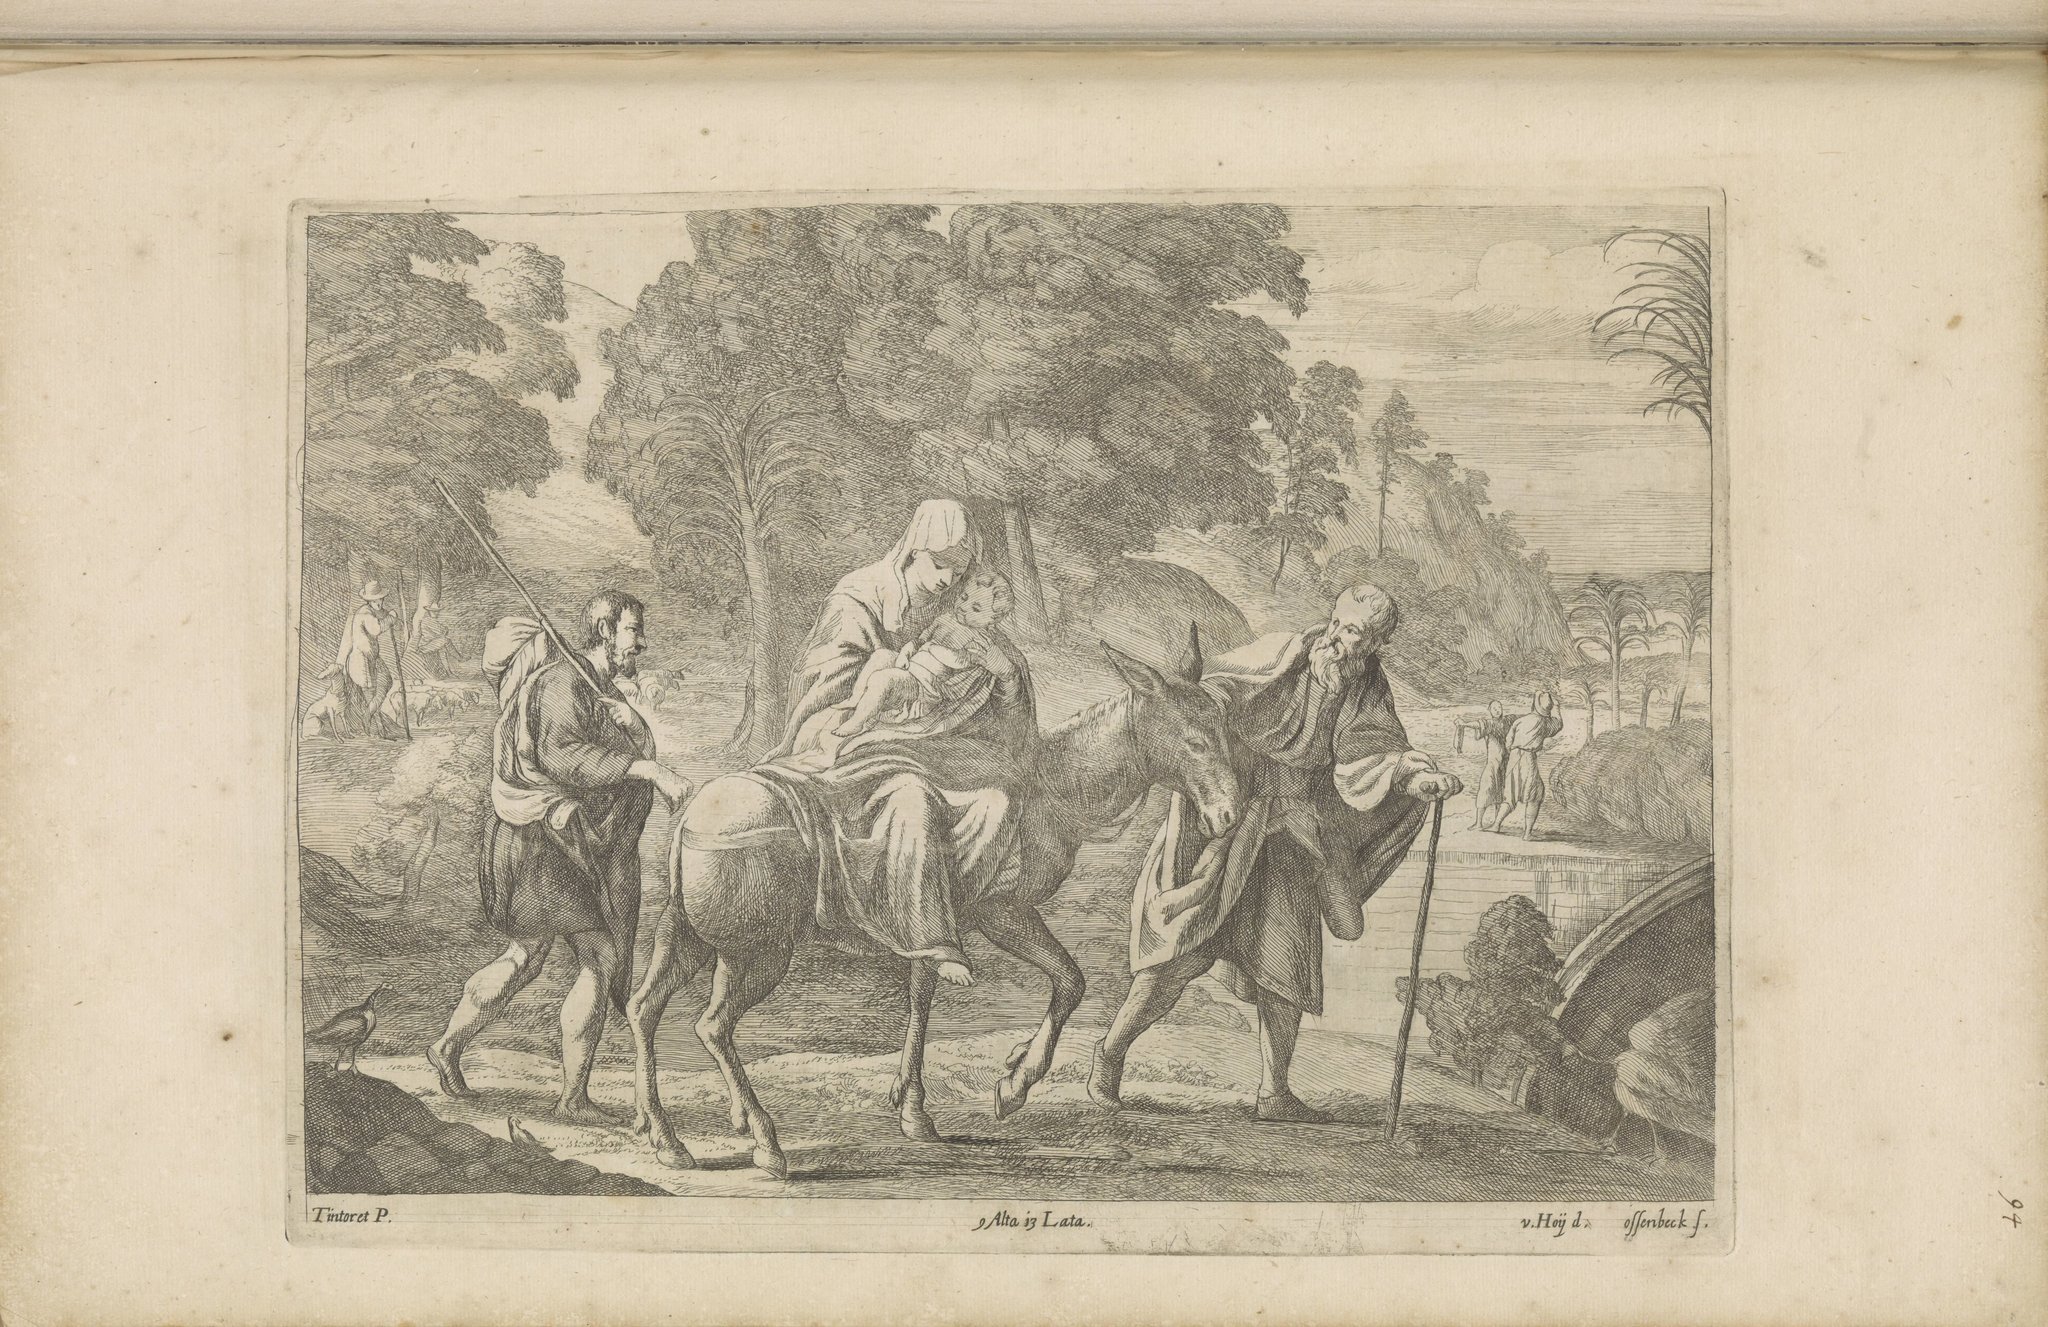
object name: album leaf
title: Vlucht naar Egypte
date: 1660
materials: paper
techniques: etching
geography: brussels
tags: the flight into egypt: mary, joseph, the child (and sometimes others) on their way; mary usually riding on an ass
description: David Teniers heeft waarschijnlijk van alle schilderijen uit de collectie van Leopold Willem van Oostenrijk een olieverfstudie op doek of paneel vervaardigd (zgn. pasticcio), die als voorbeeld voor de prentmakers diende. Het is niet altijd duidelijk of de pasticci door hem zijn gemaakt of door zijn atelier. Niet alle pasticci zijn overgeleverd.